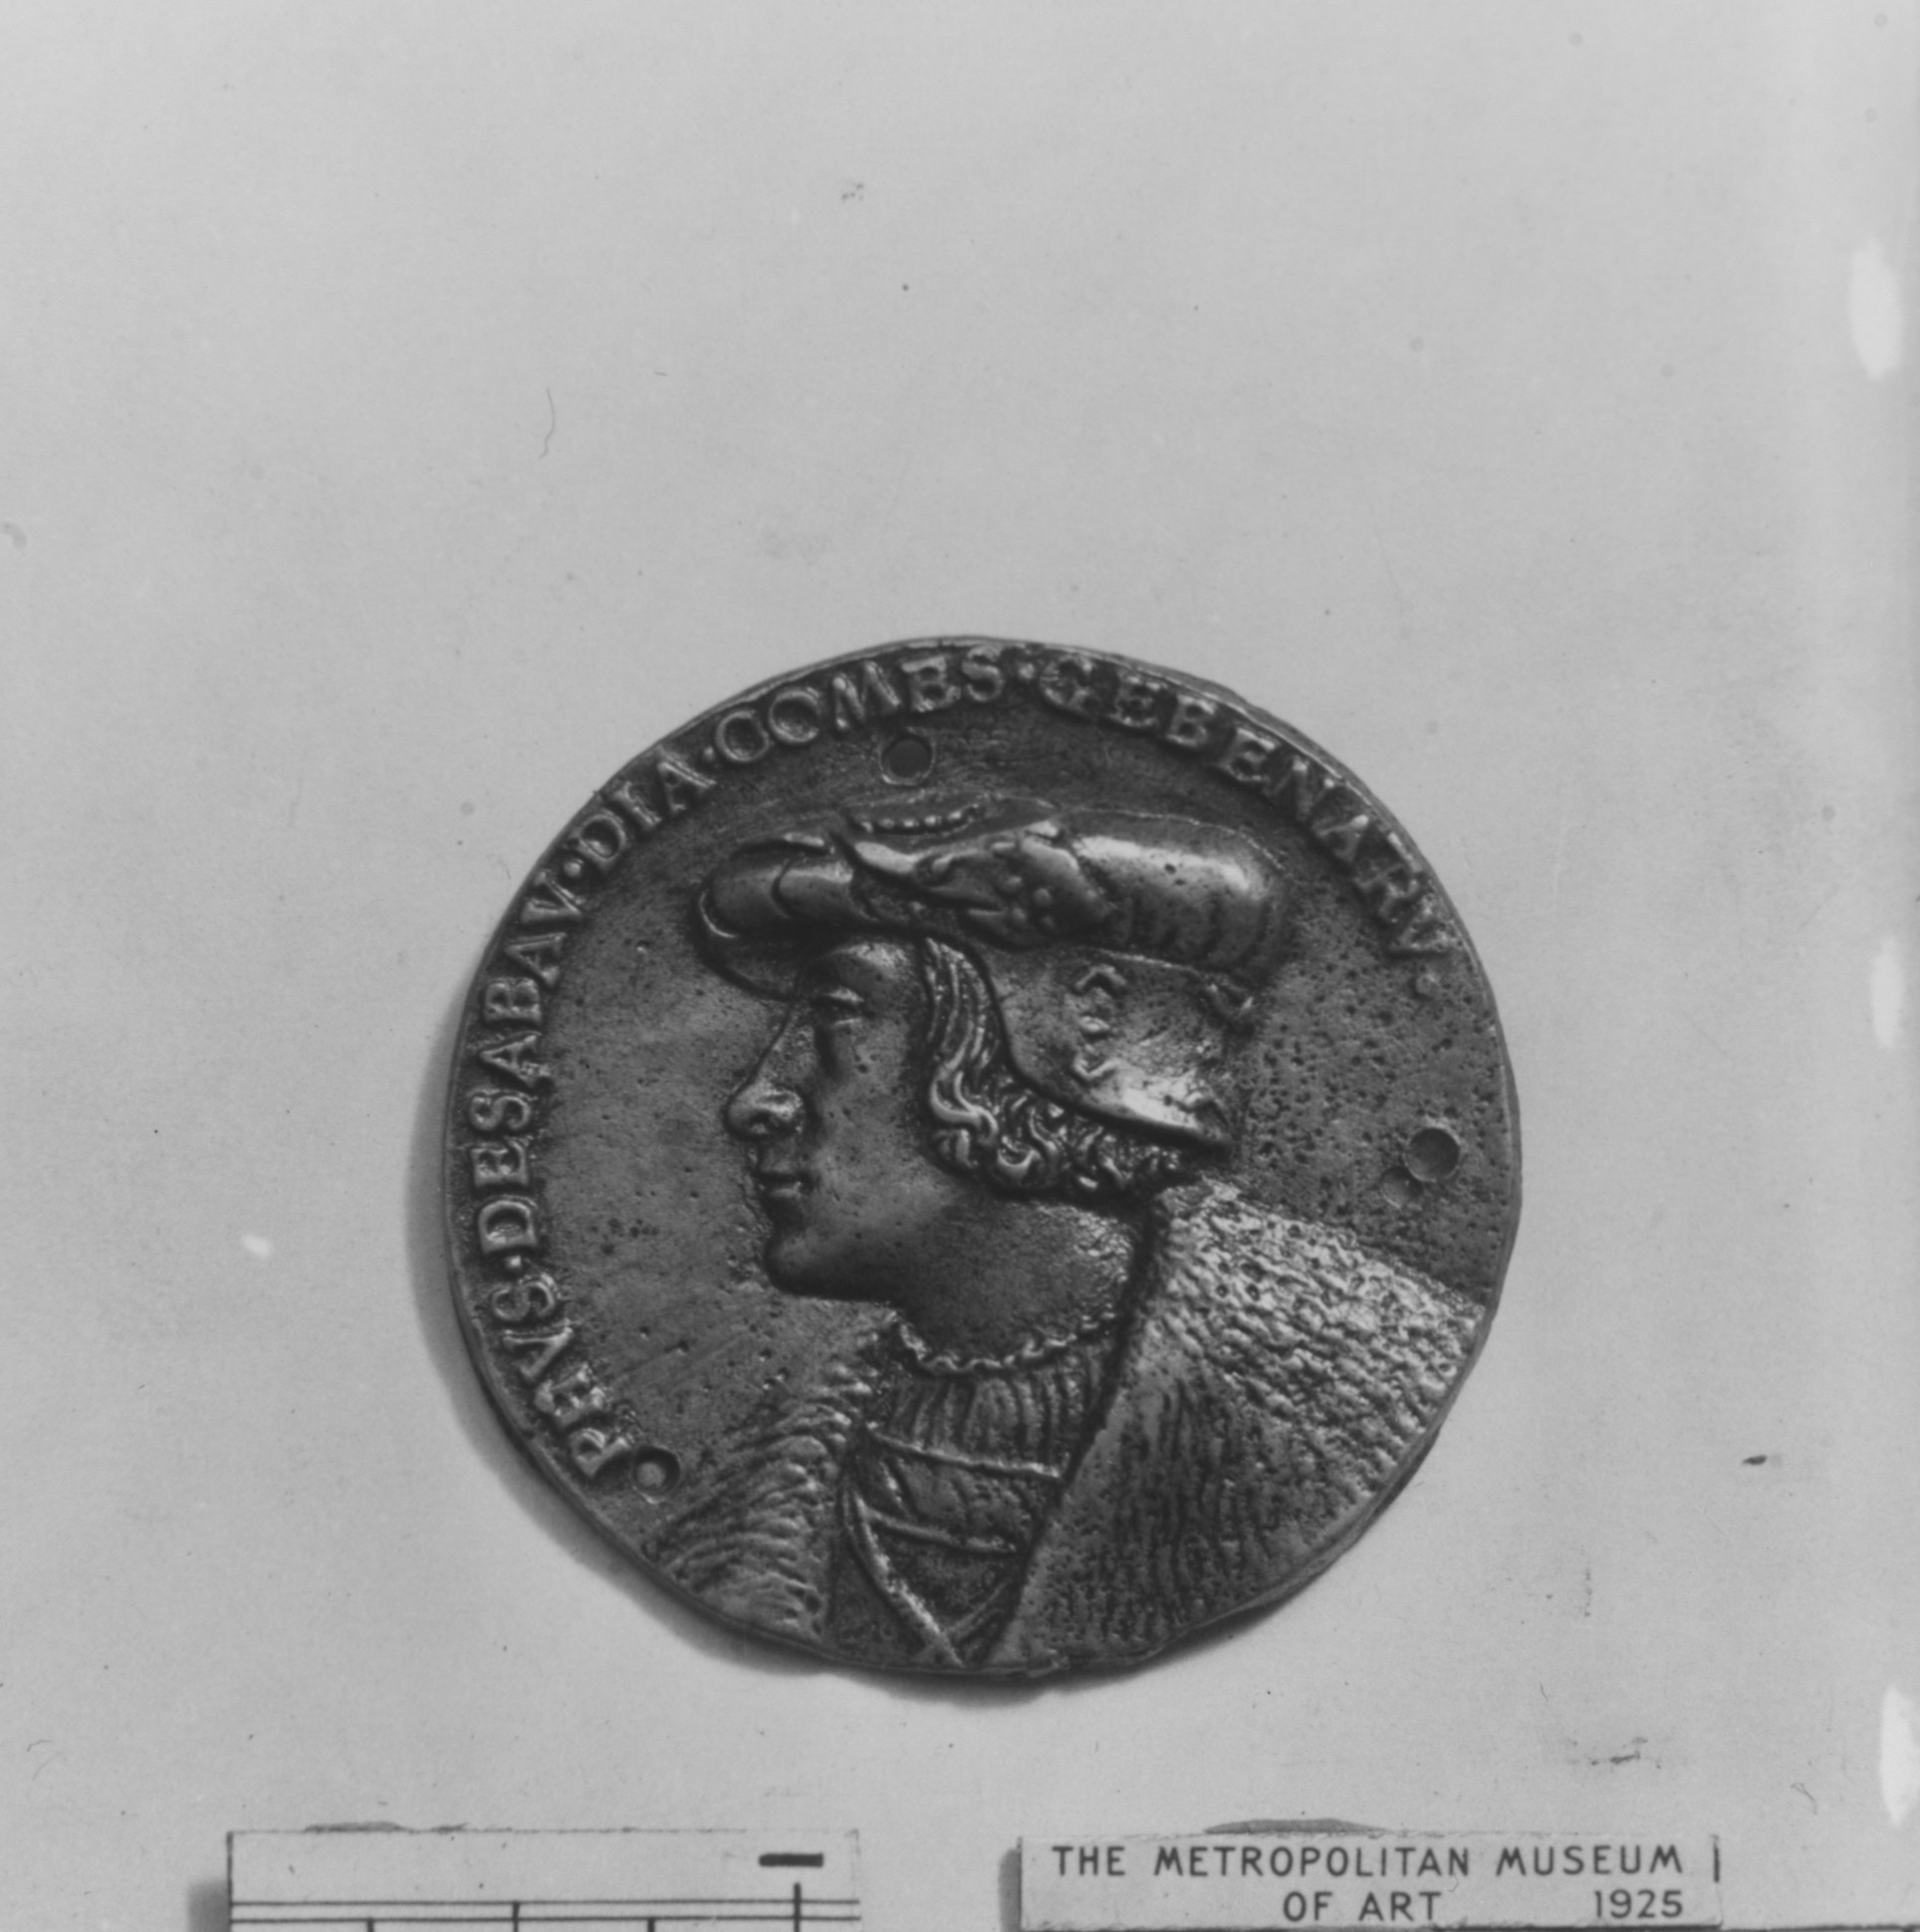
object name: medal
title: Philip of Savoy, Count of Genevois (ca. 1490–1533)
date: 1514-1528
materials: bronze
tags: men,profiles